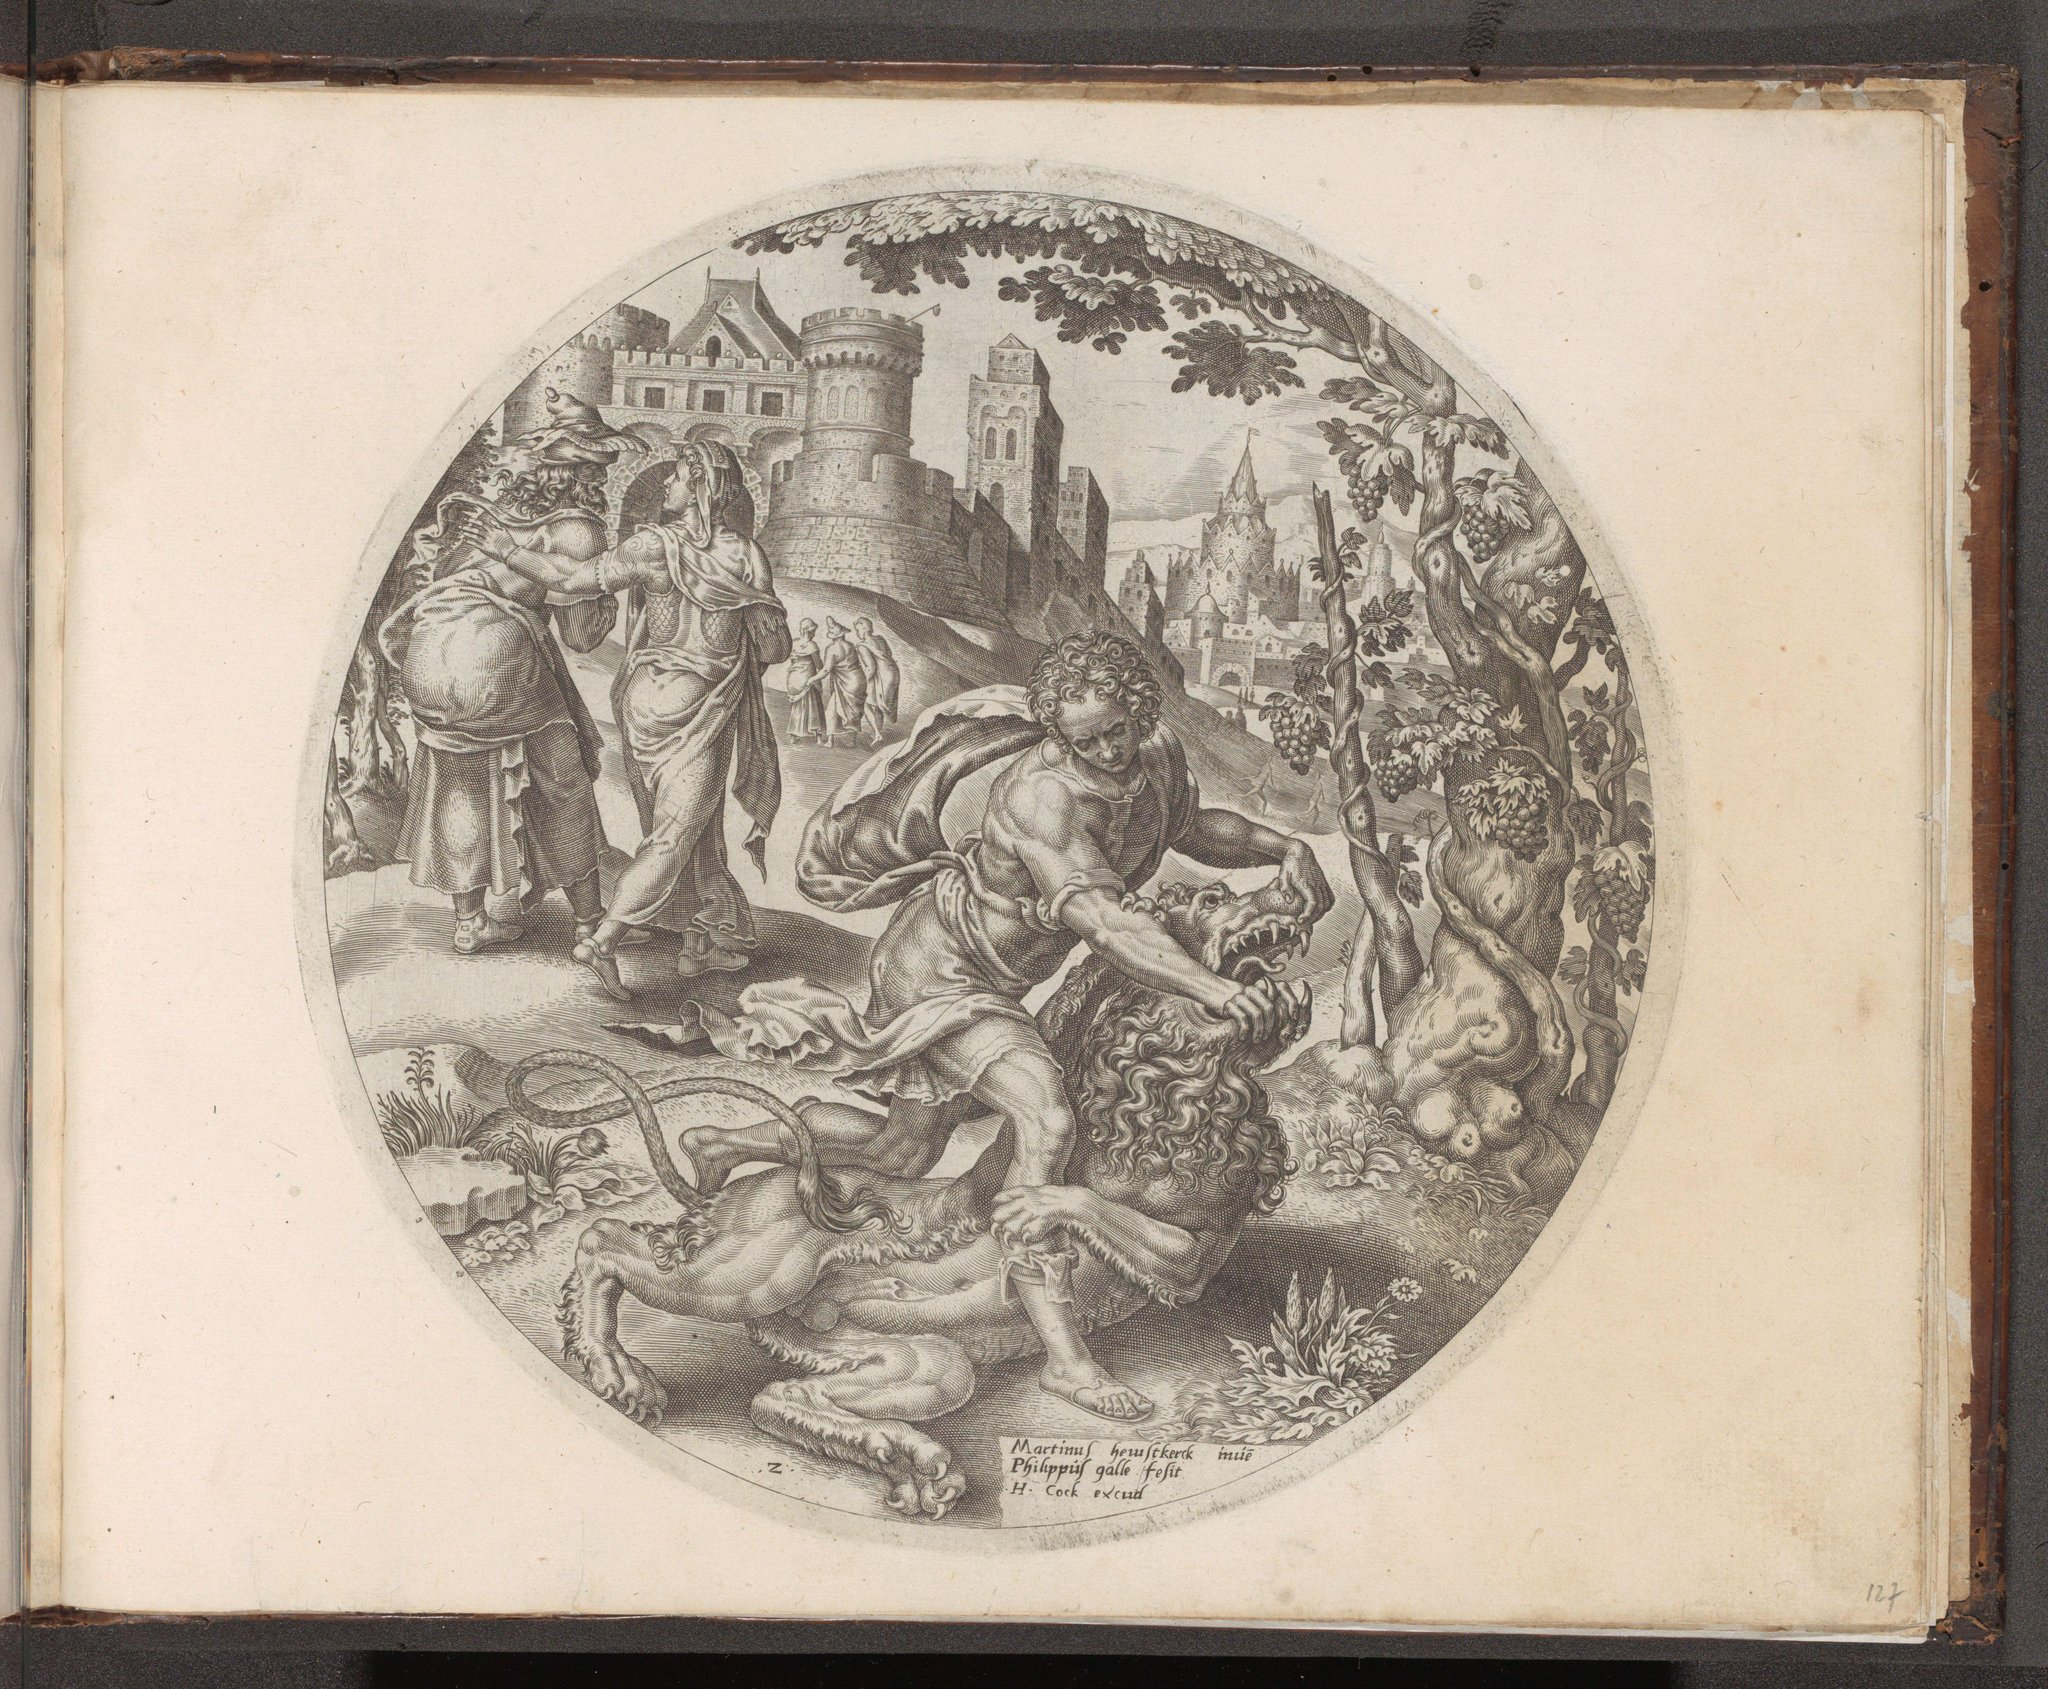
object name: album leaf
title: Simson doodt de leeuw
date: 1558-1562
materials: paper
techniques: engraving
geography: antwerp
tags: samson kills the lion with his bare hands, samson and his parents on their journey to timnath, in the vineyards of timnath samson meets a roaring lion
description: Simson doodt bij de wijngaarden van Timna met zijn blote handen een leeuw, door de kaken van het dier uiteen te trekken. Links lopen de ouders van Simson met wie hij onderweg is naar Timna. Prent maakt deel uit van een album.